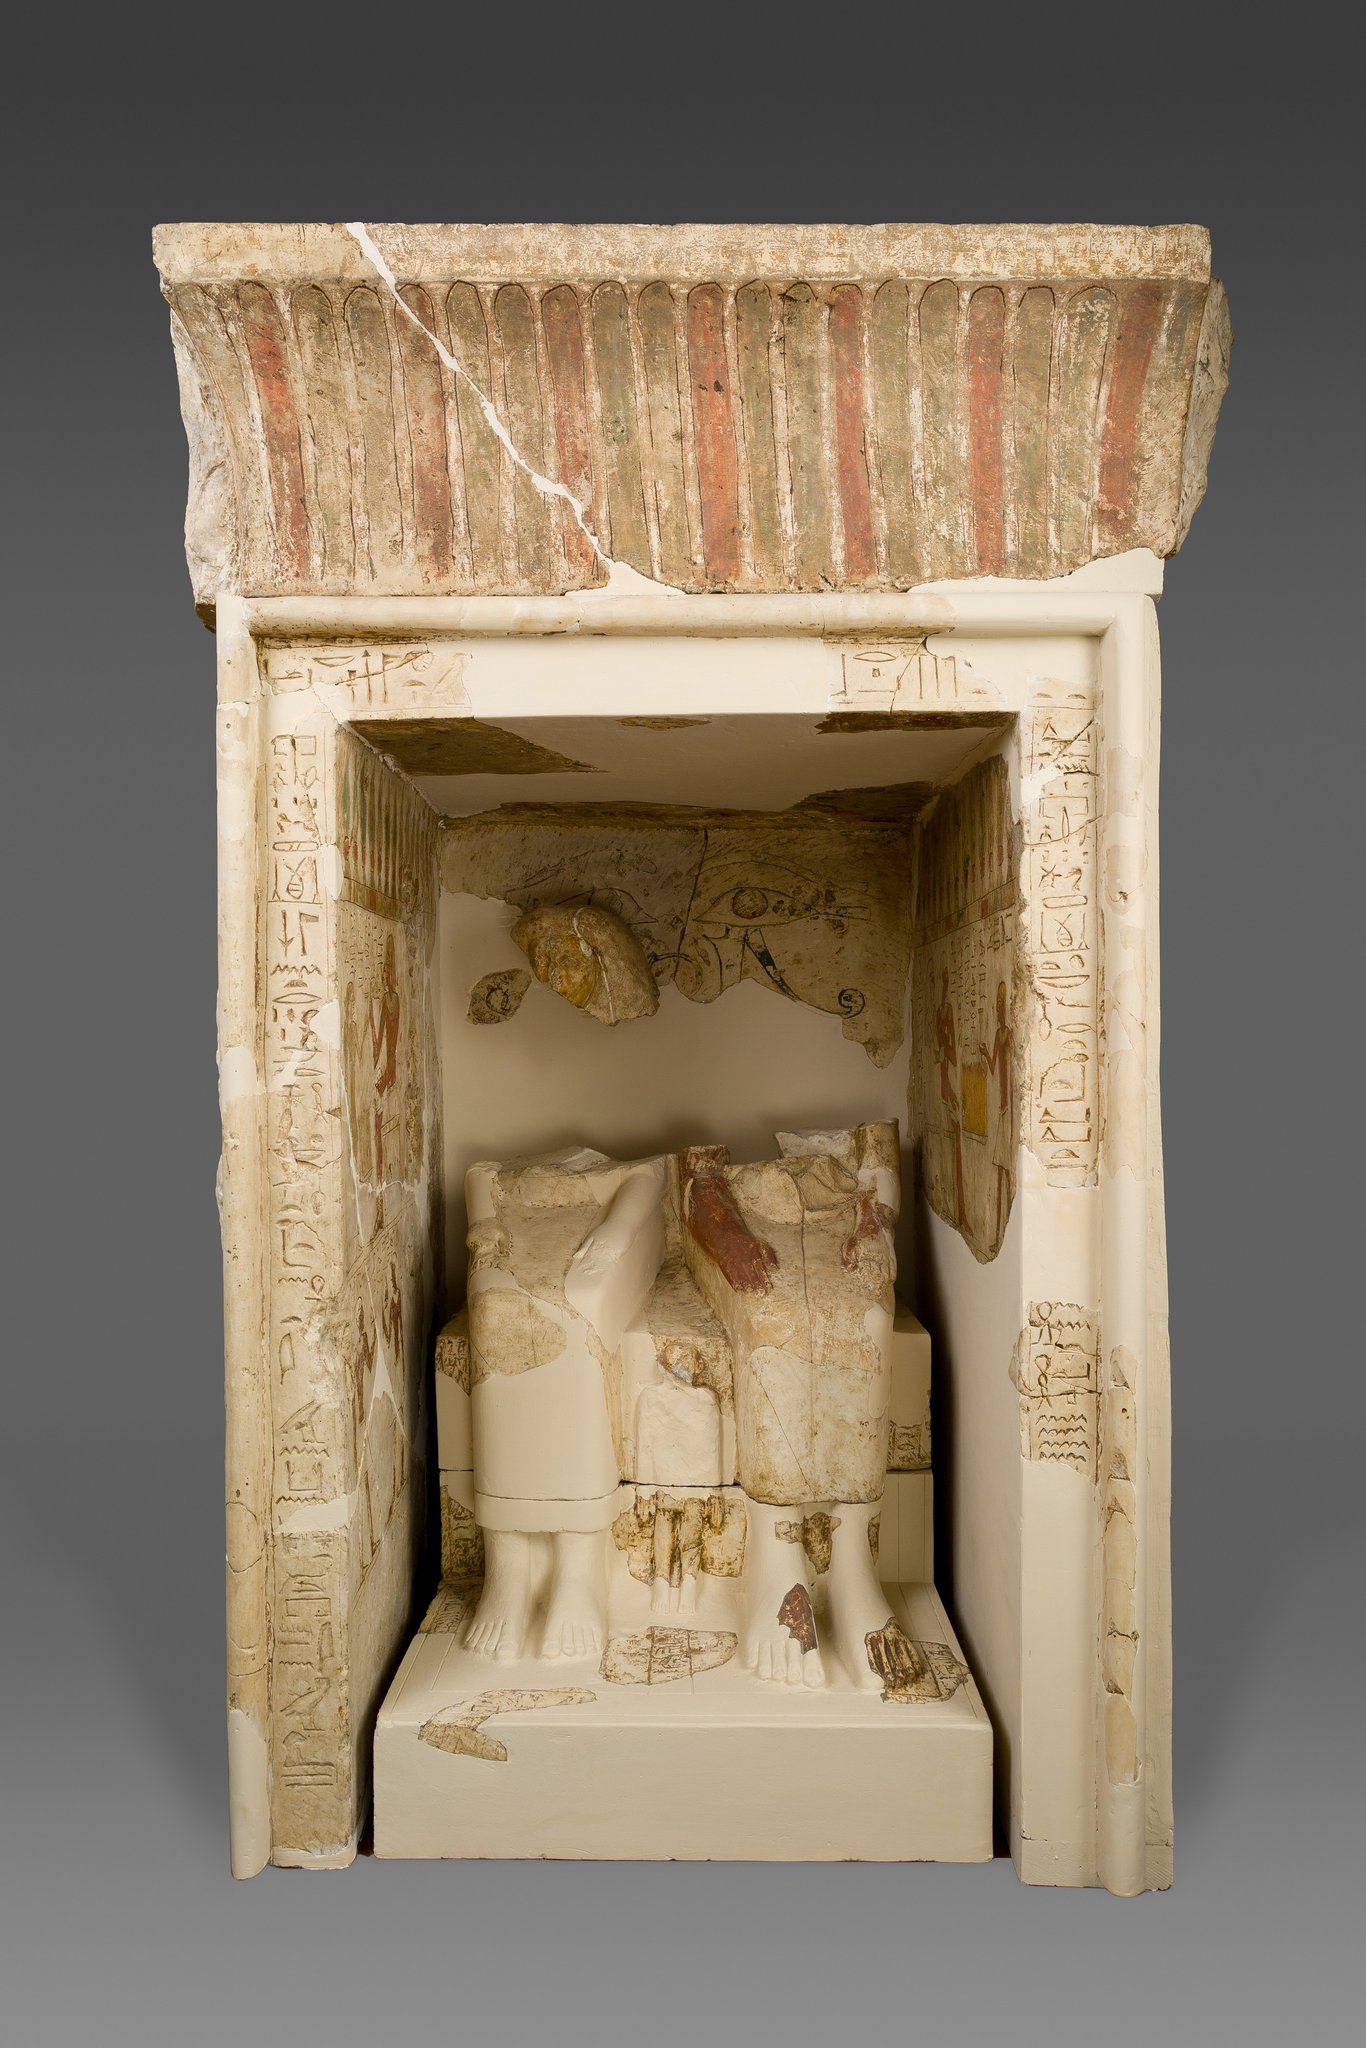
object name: shrine, amenemhat, neferu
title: Shrine with statues of Amenemhat and his wife Neferu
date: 1850-1750 BCE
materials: limestone, paint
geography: egypt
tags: couples,men,women